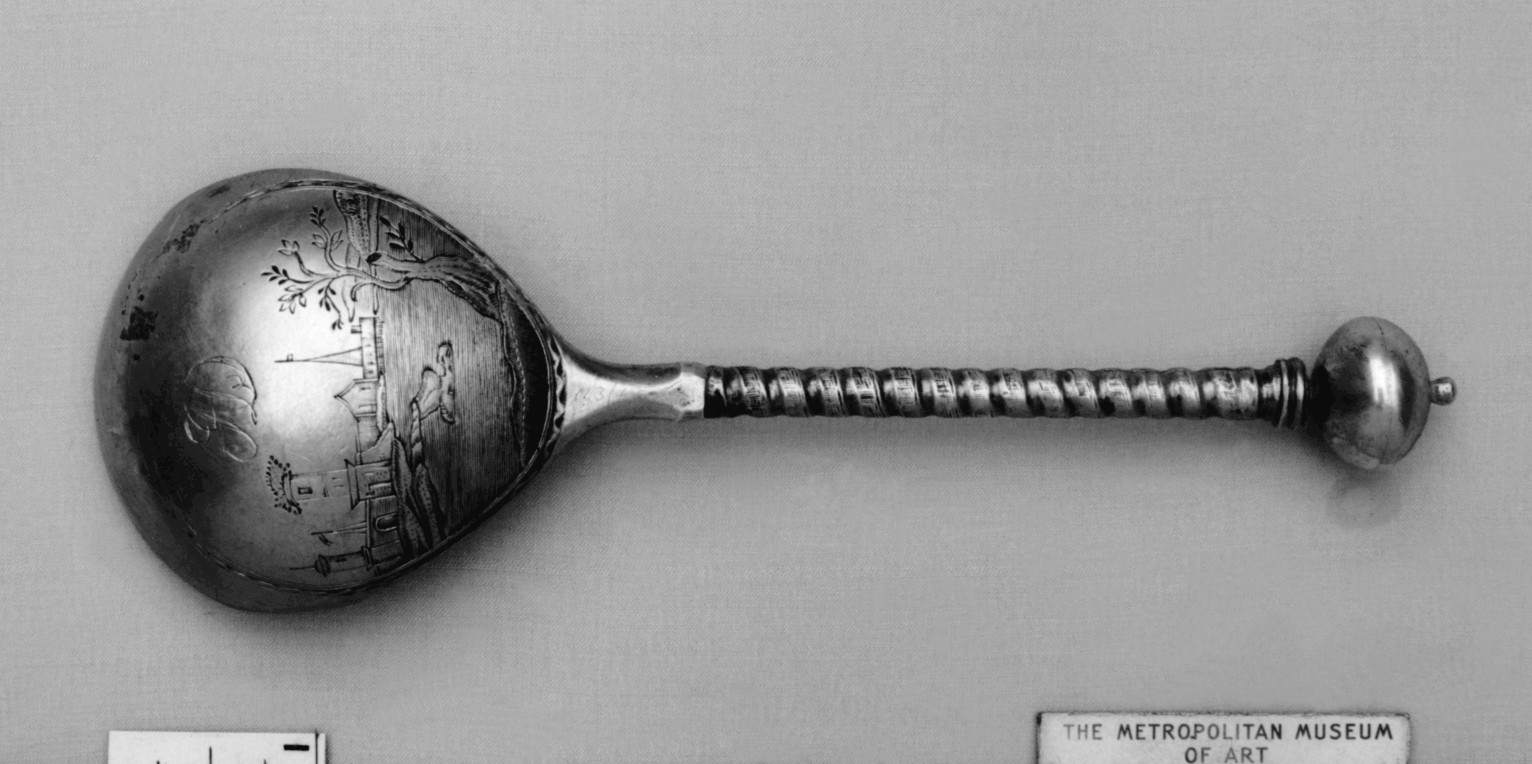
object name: spoon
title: Ball-knopped spoon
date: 1601-1700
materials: silver gilt